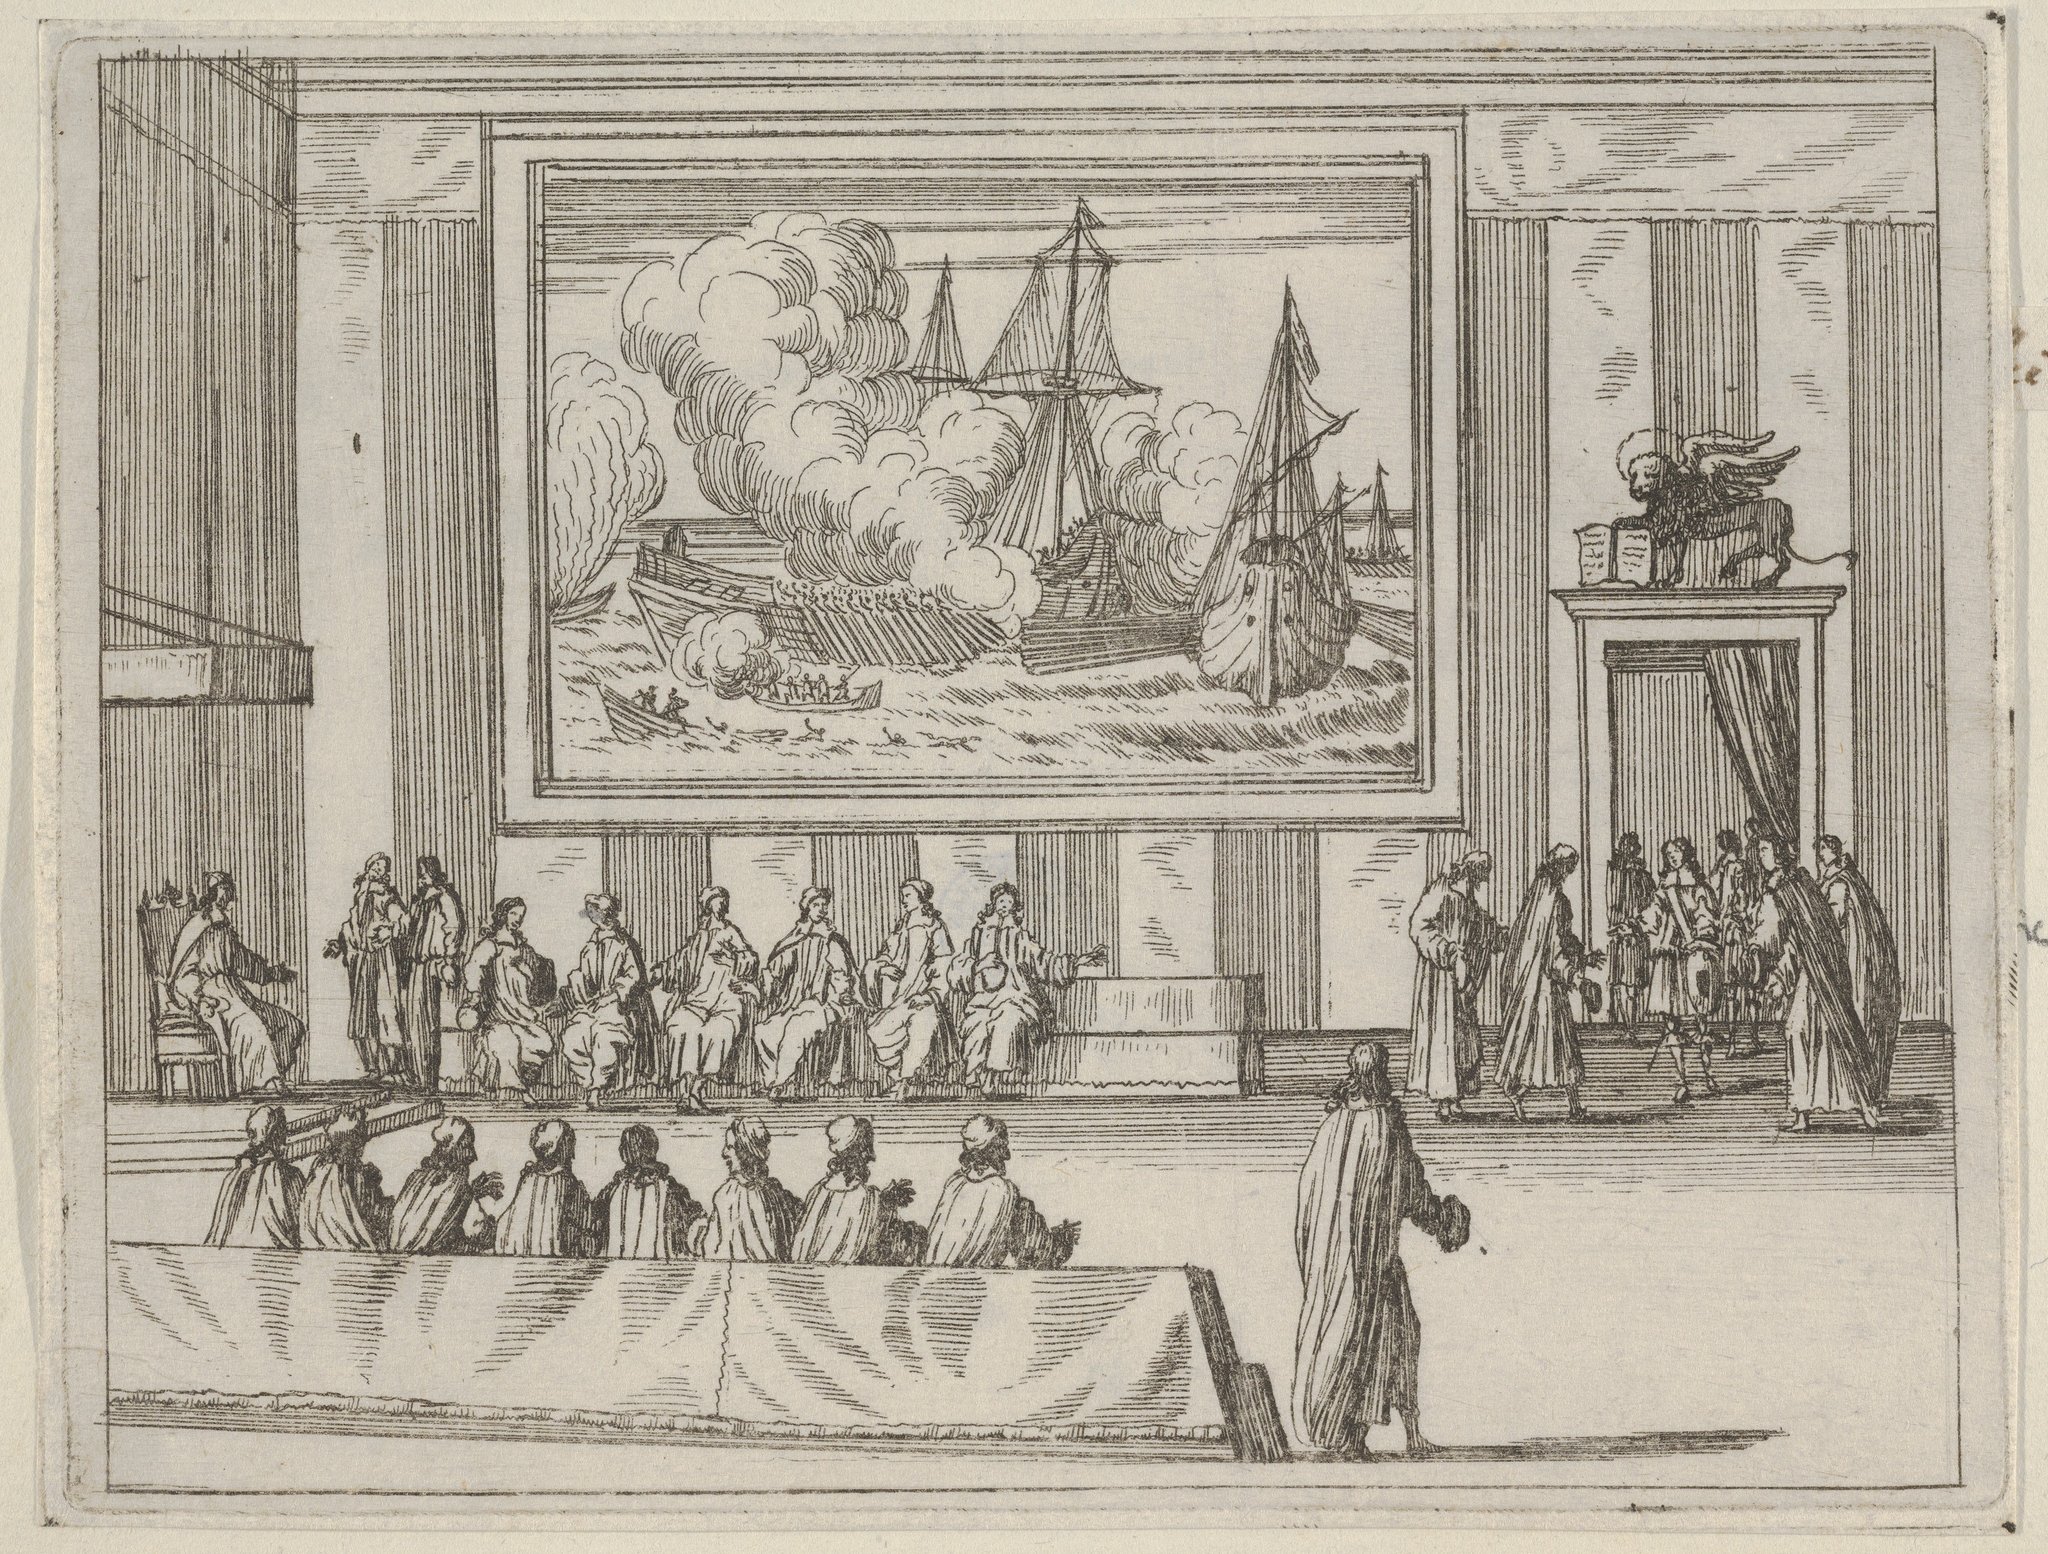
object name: print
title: Francesco I d'Este Presents Himself with Warmth and Humility with Representatives of the Republic of Venice and the Duke of Savoy, from "L'Idea di un Principe ed Eroe Cristiano in Francesco I d'Este, di Modena e Reggio Duca VIII [...]"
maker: bartolomeo fenice (fénis)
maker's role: artist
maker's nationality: italian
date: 1659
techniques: etching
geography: italy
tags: human figures,interiors,venice